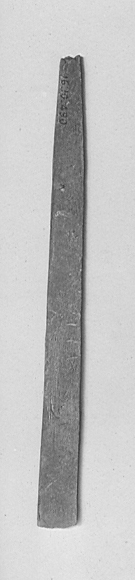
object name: chisel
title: Inscribed Chisel From Foundation Deposit 2 of Hatshepsut's Valley Temple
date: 1479-1458 BCE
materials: bronze, copper alloy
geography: egypt